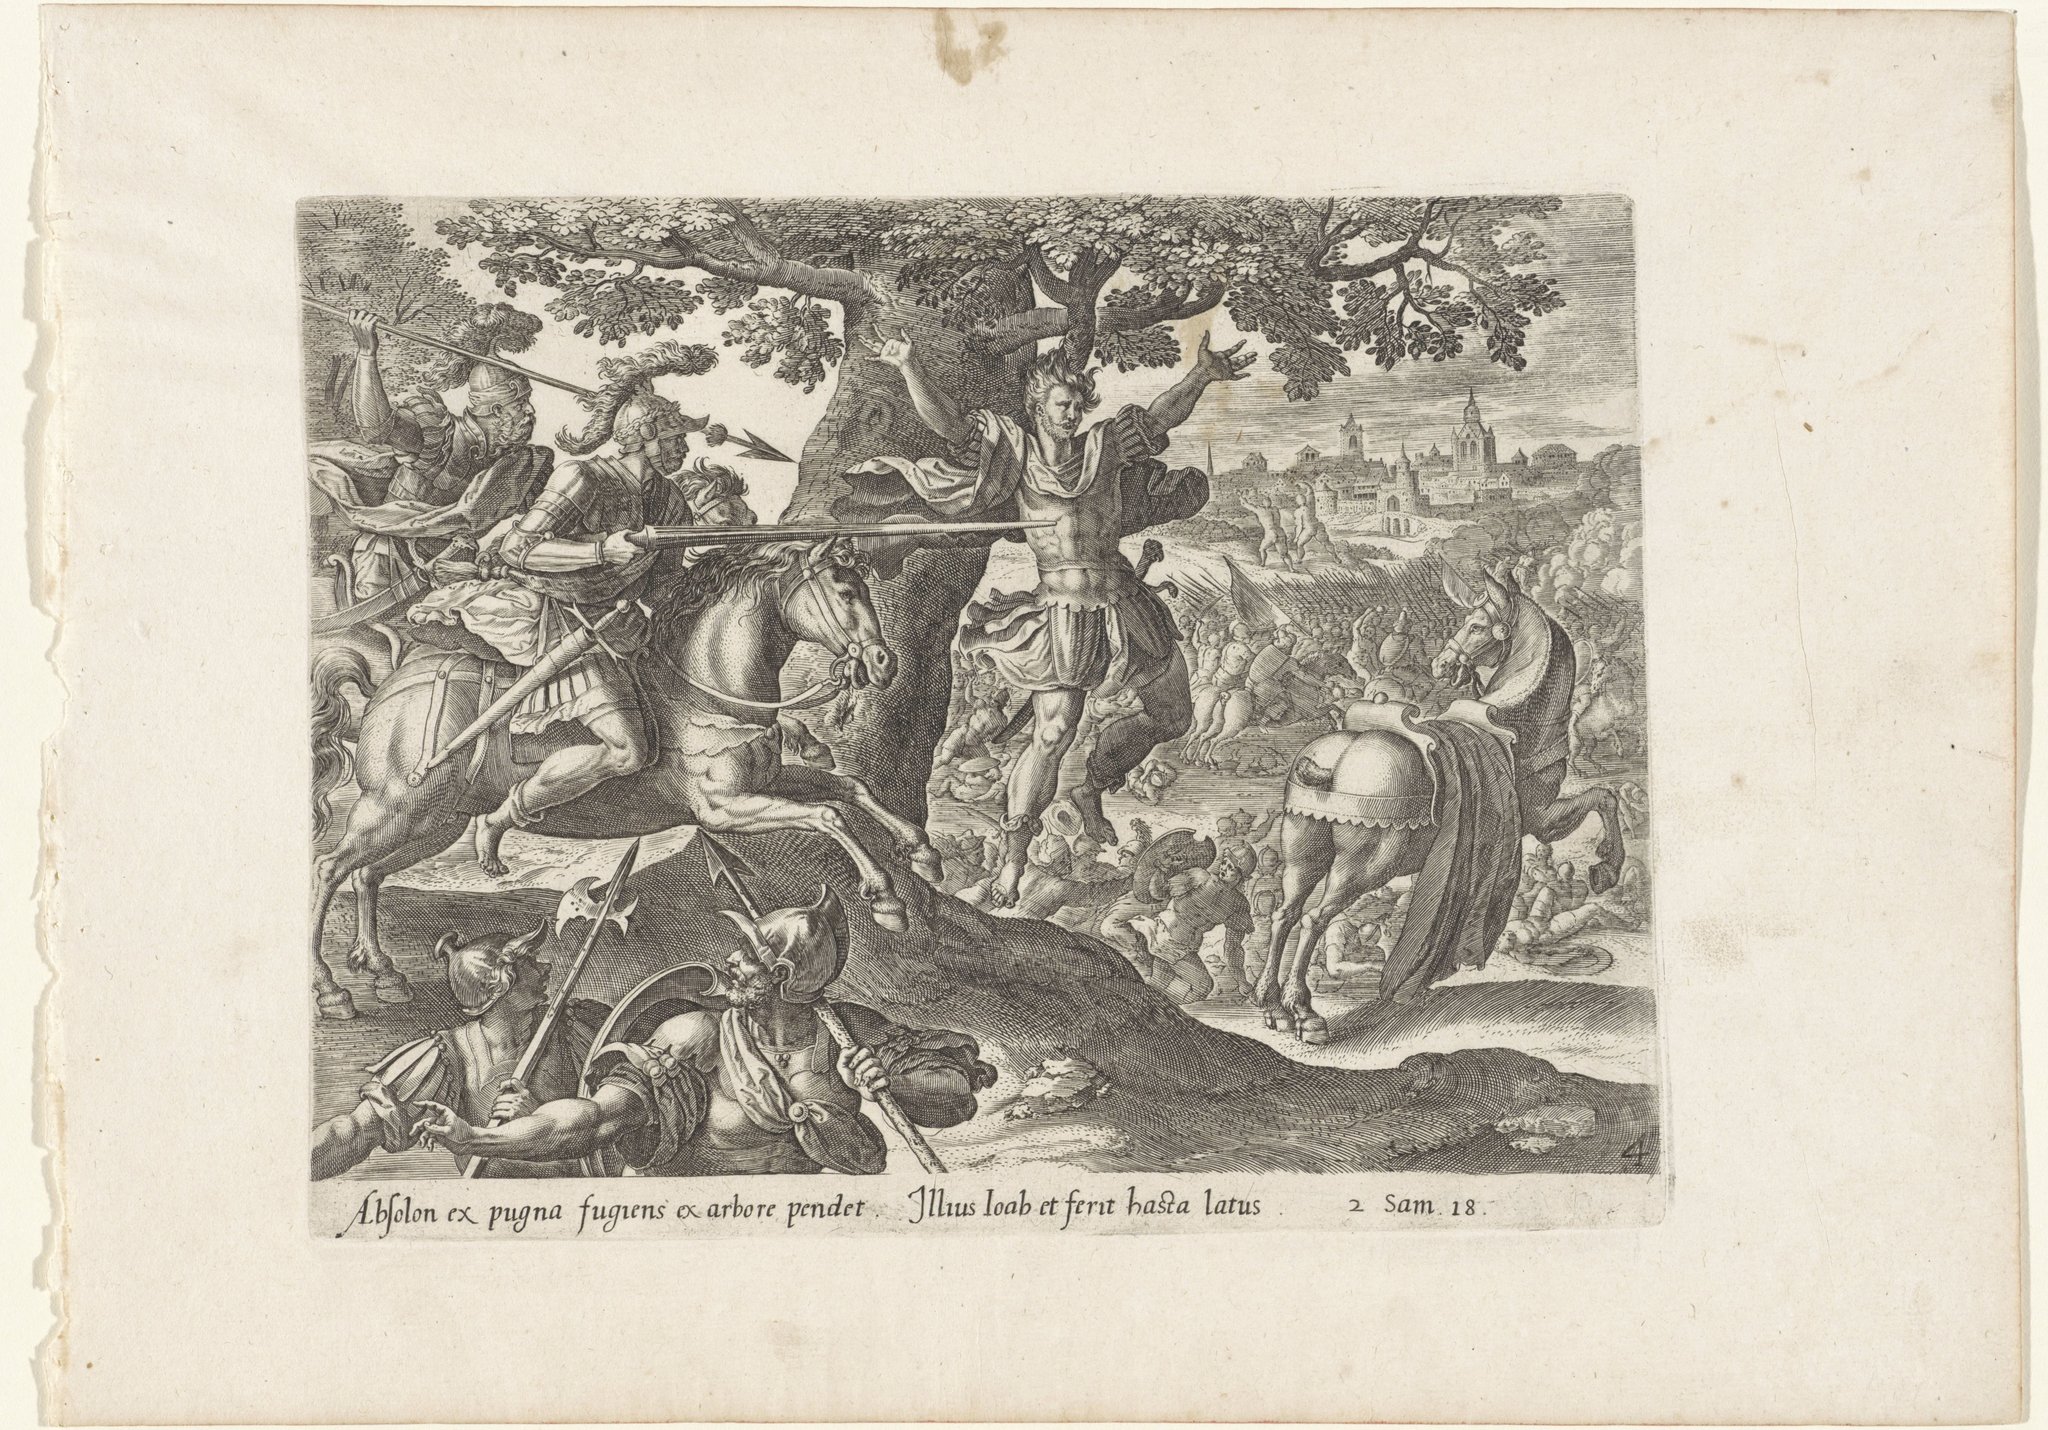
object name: print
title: Geschiedenis van David en Absalom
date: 1585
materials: paper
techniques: engraving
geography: antwerp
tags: absalom, put to flight on a mule, remains hanging by his hair in an oak-tree, joab stabs absalom with three spears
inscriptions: collector's mark: Lugt 2760, collector's mark: Lugt 2228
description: Prent gebruikt in: Thesaurus sacrarum historiaru[m] veteris (et novi) testame[n]ti, elega[n]tissimis imaginibus expressu[m] excelle[n]tissimoru[m] in hac arte viroru[m] opera : nu[n]c primu[m] in luce[m] editus. Antwerpen: Gerard de Jode, 1585.